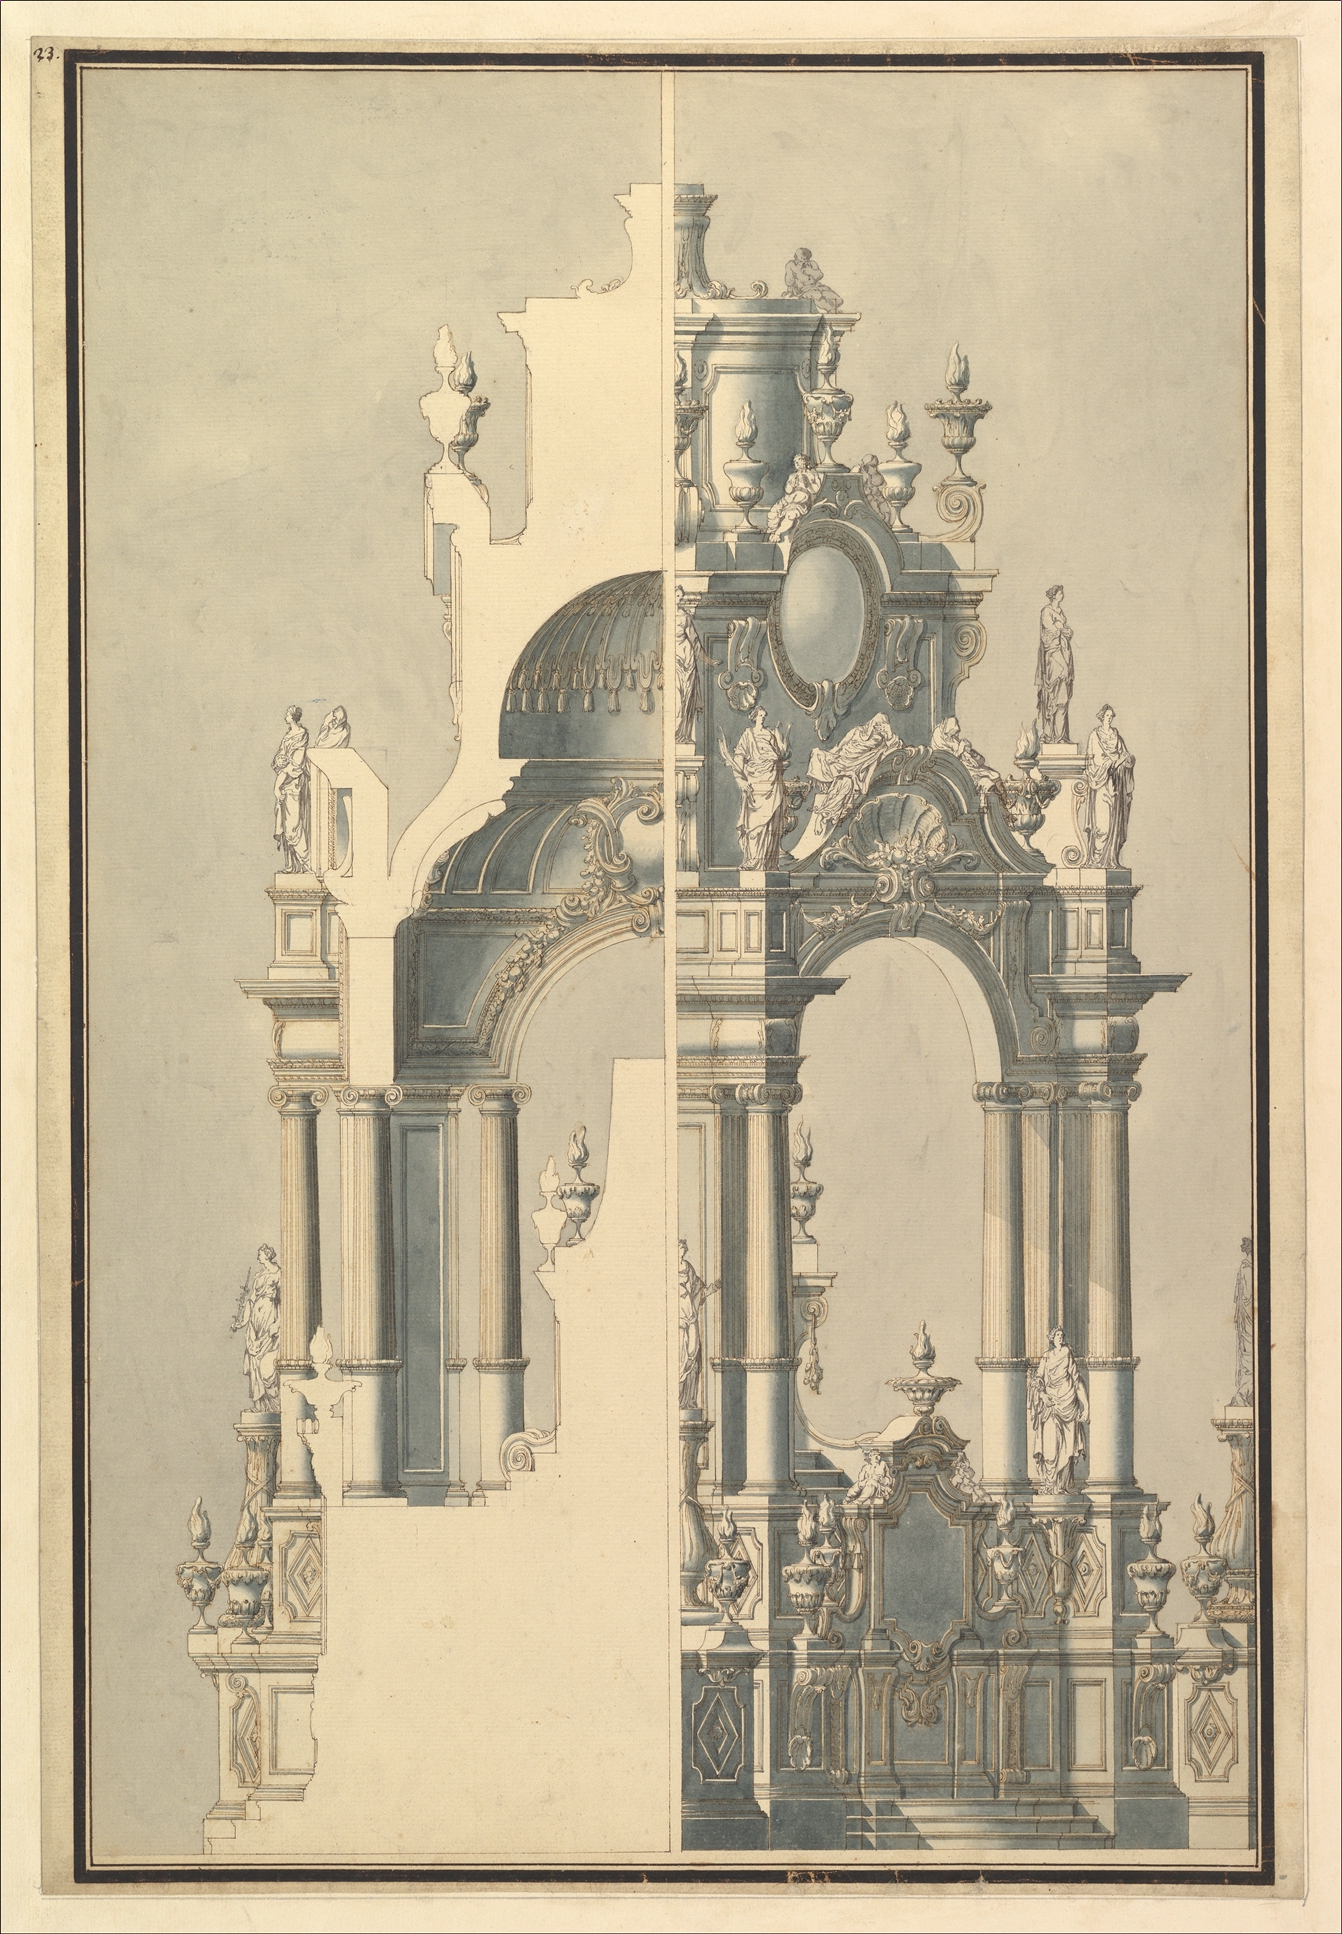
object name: drawing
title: Elevation and Section for a Catafalque for the Dauphin of France, d. 1711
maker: giuseppe galli bibiena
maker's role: artist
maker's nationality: italian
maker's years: 1696-1756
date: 1711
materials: graphite, ink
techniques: brush, pen, drawing, wash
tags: architecture